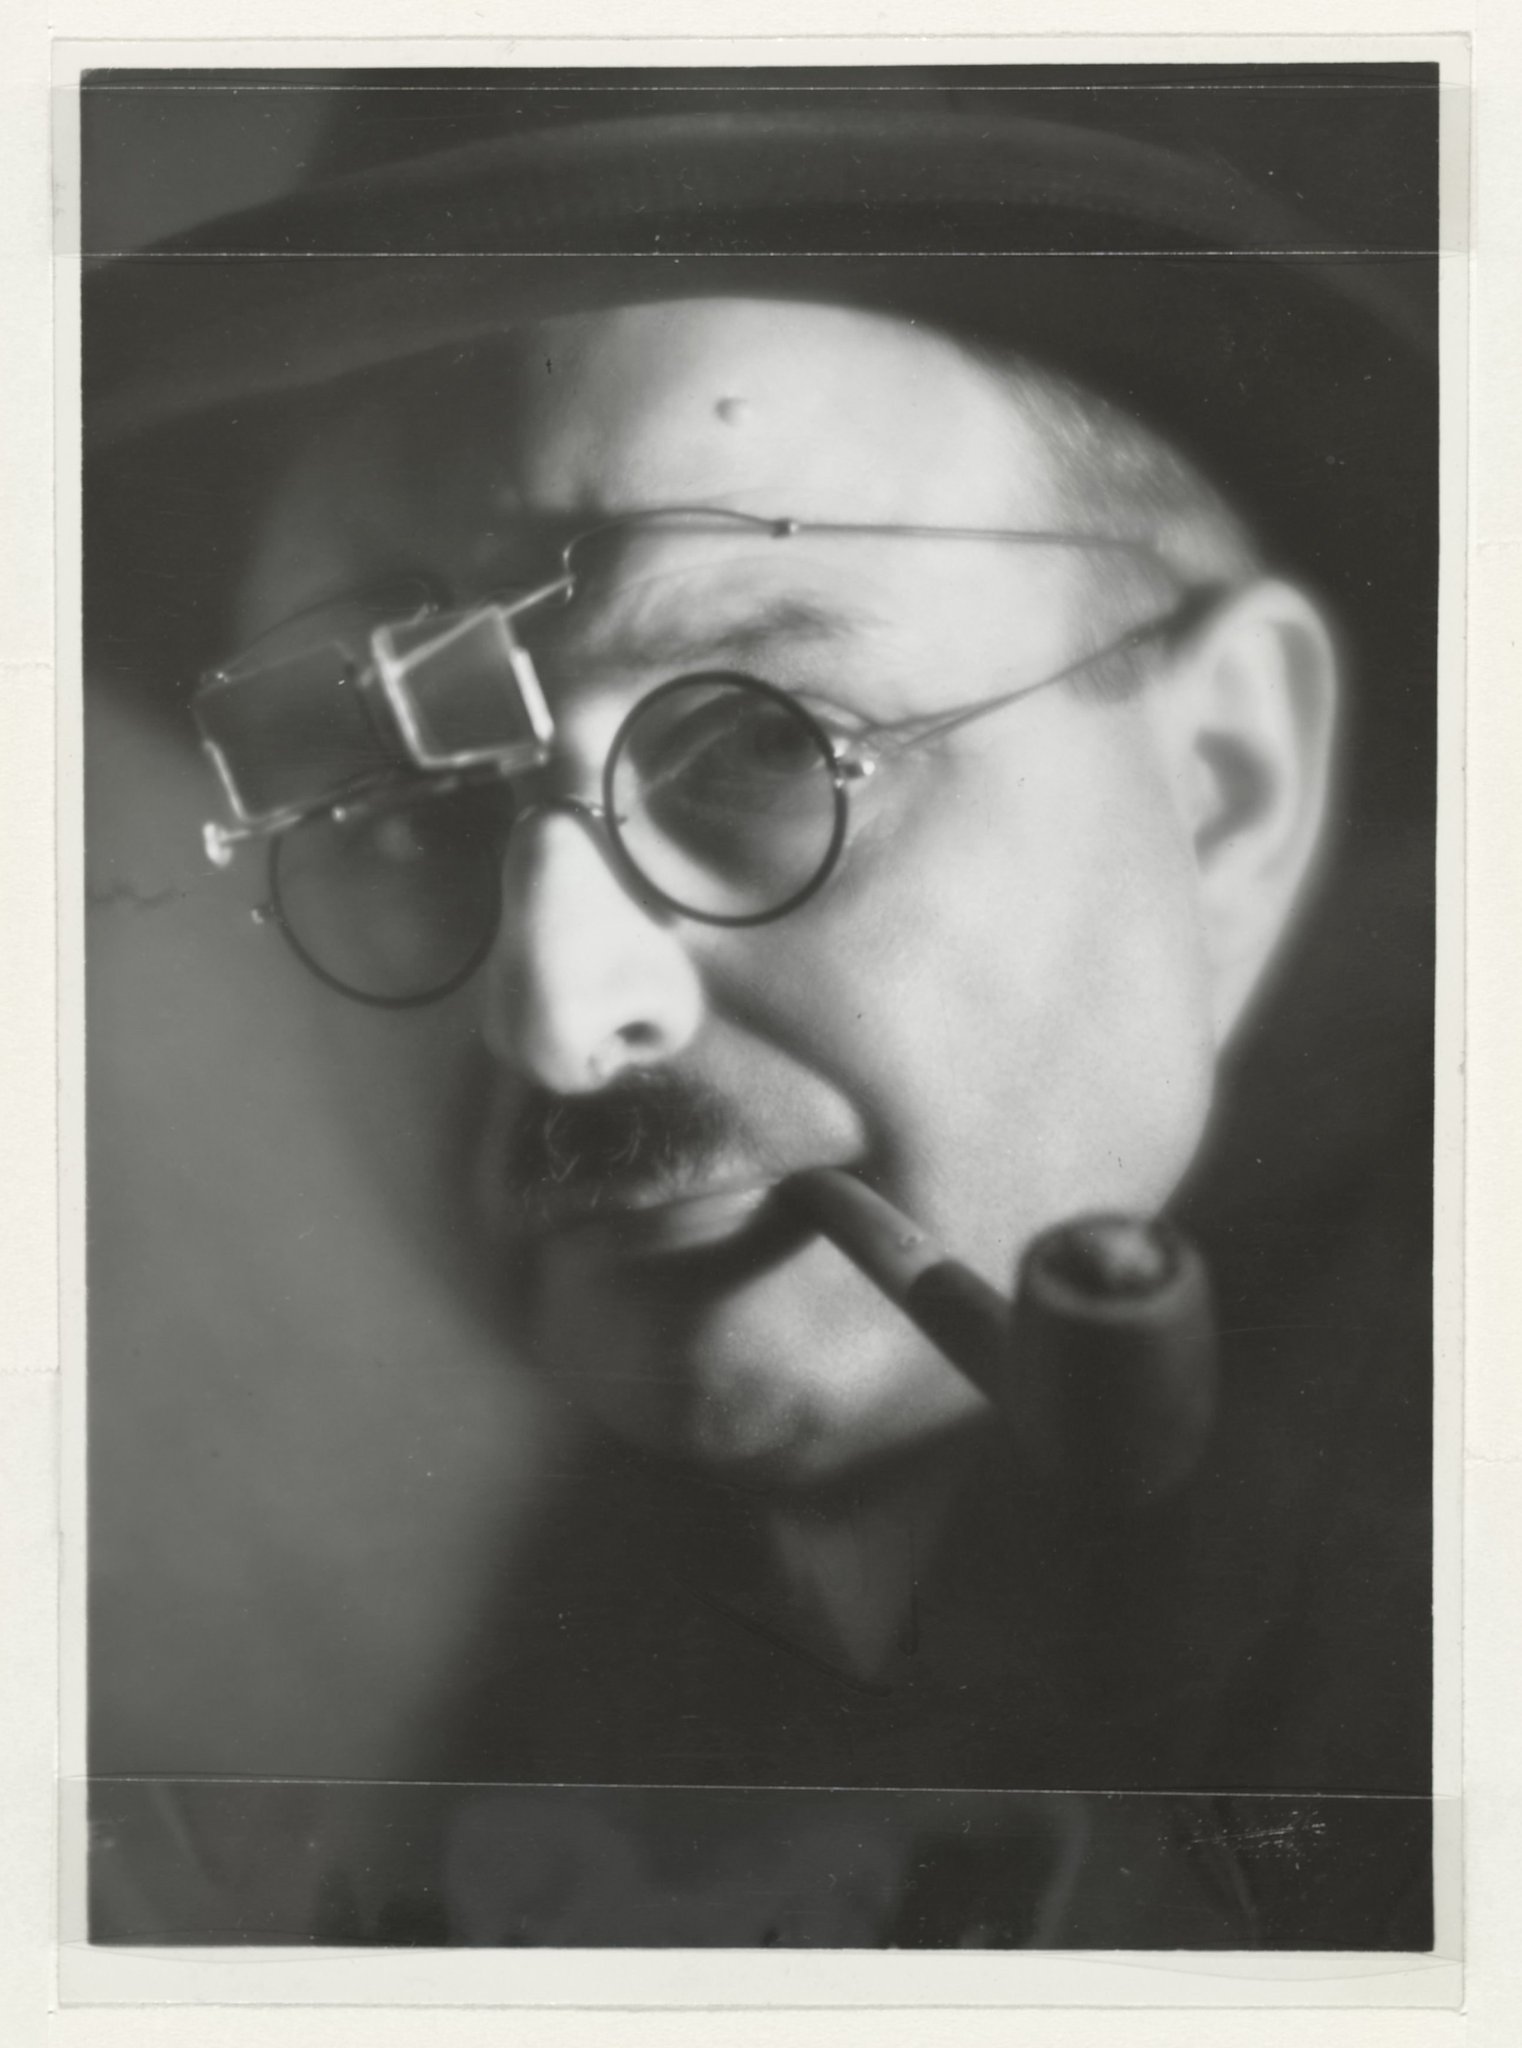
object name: photograph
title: Zelfportret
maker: jacob merkelbach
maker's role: fotograaf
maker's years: 1877-1942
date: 1920-1930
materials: photographic support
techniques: gelatin silver print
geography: amsterdam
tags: amsterdam, jacob merkelbach, portrait, self-portrait of photographer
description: Zelfportret met retoucheerbril van Jacob Merkelbach.